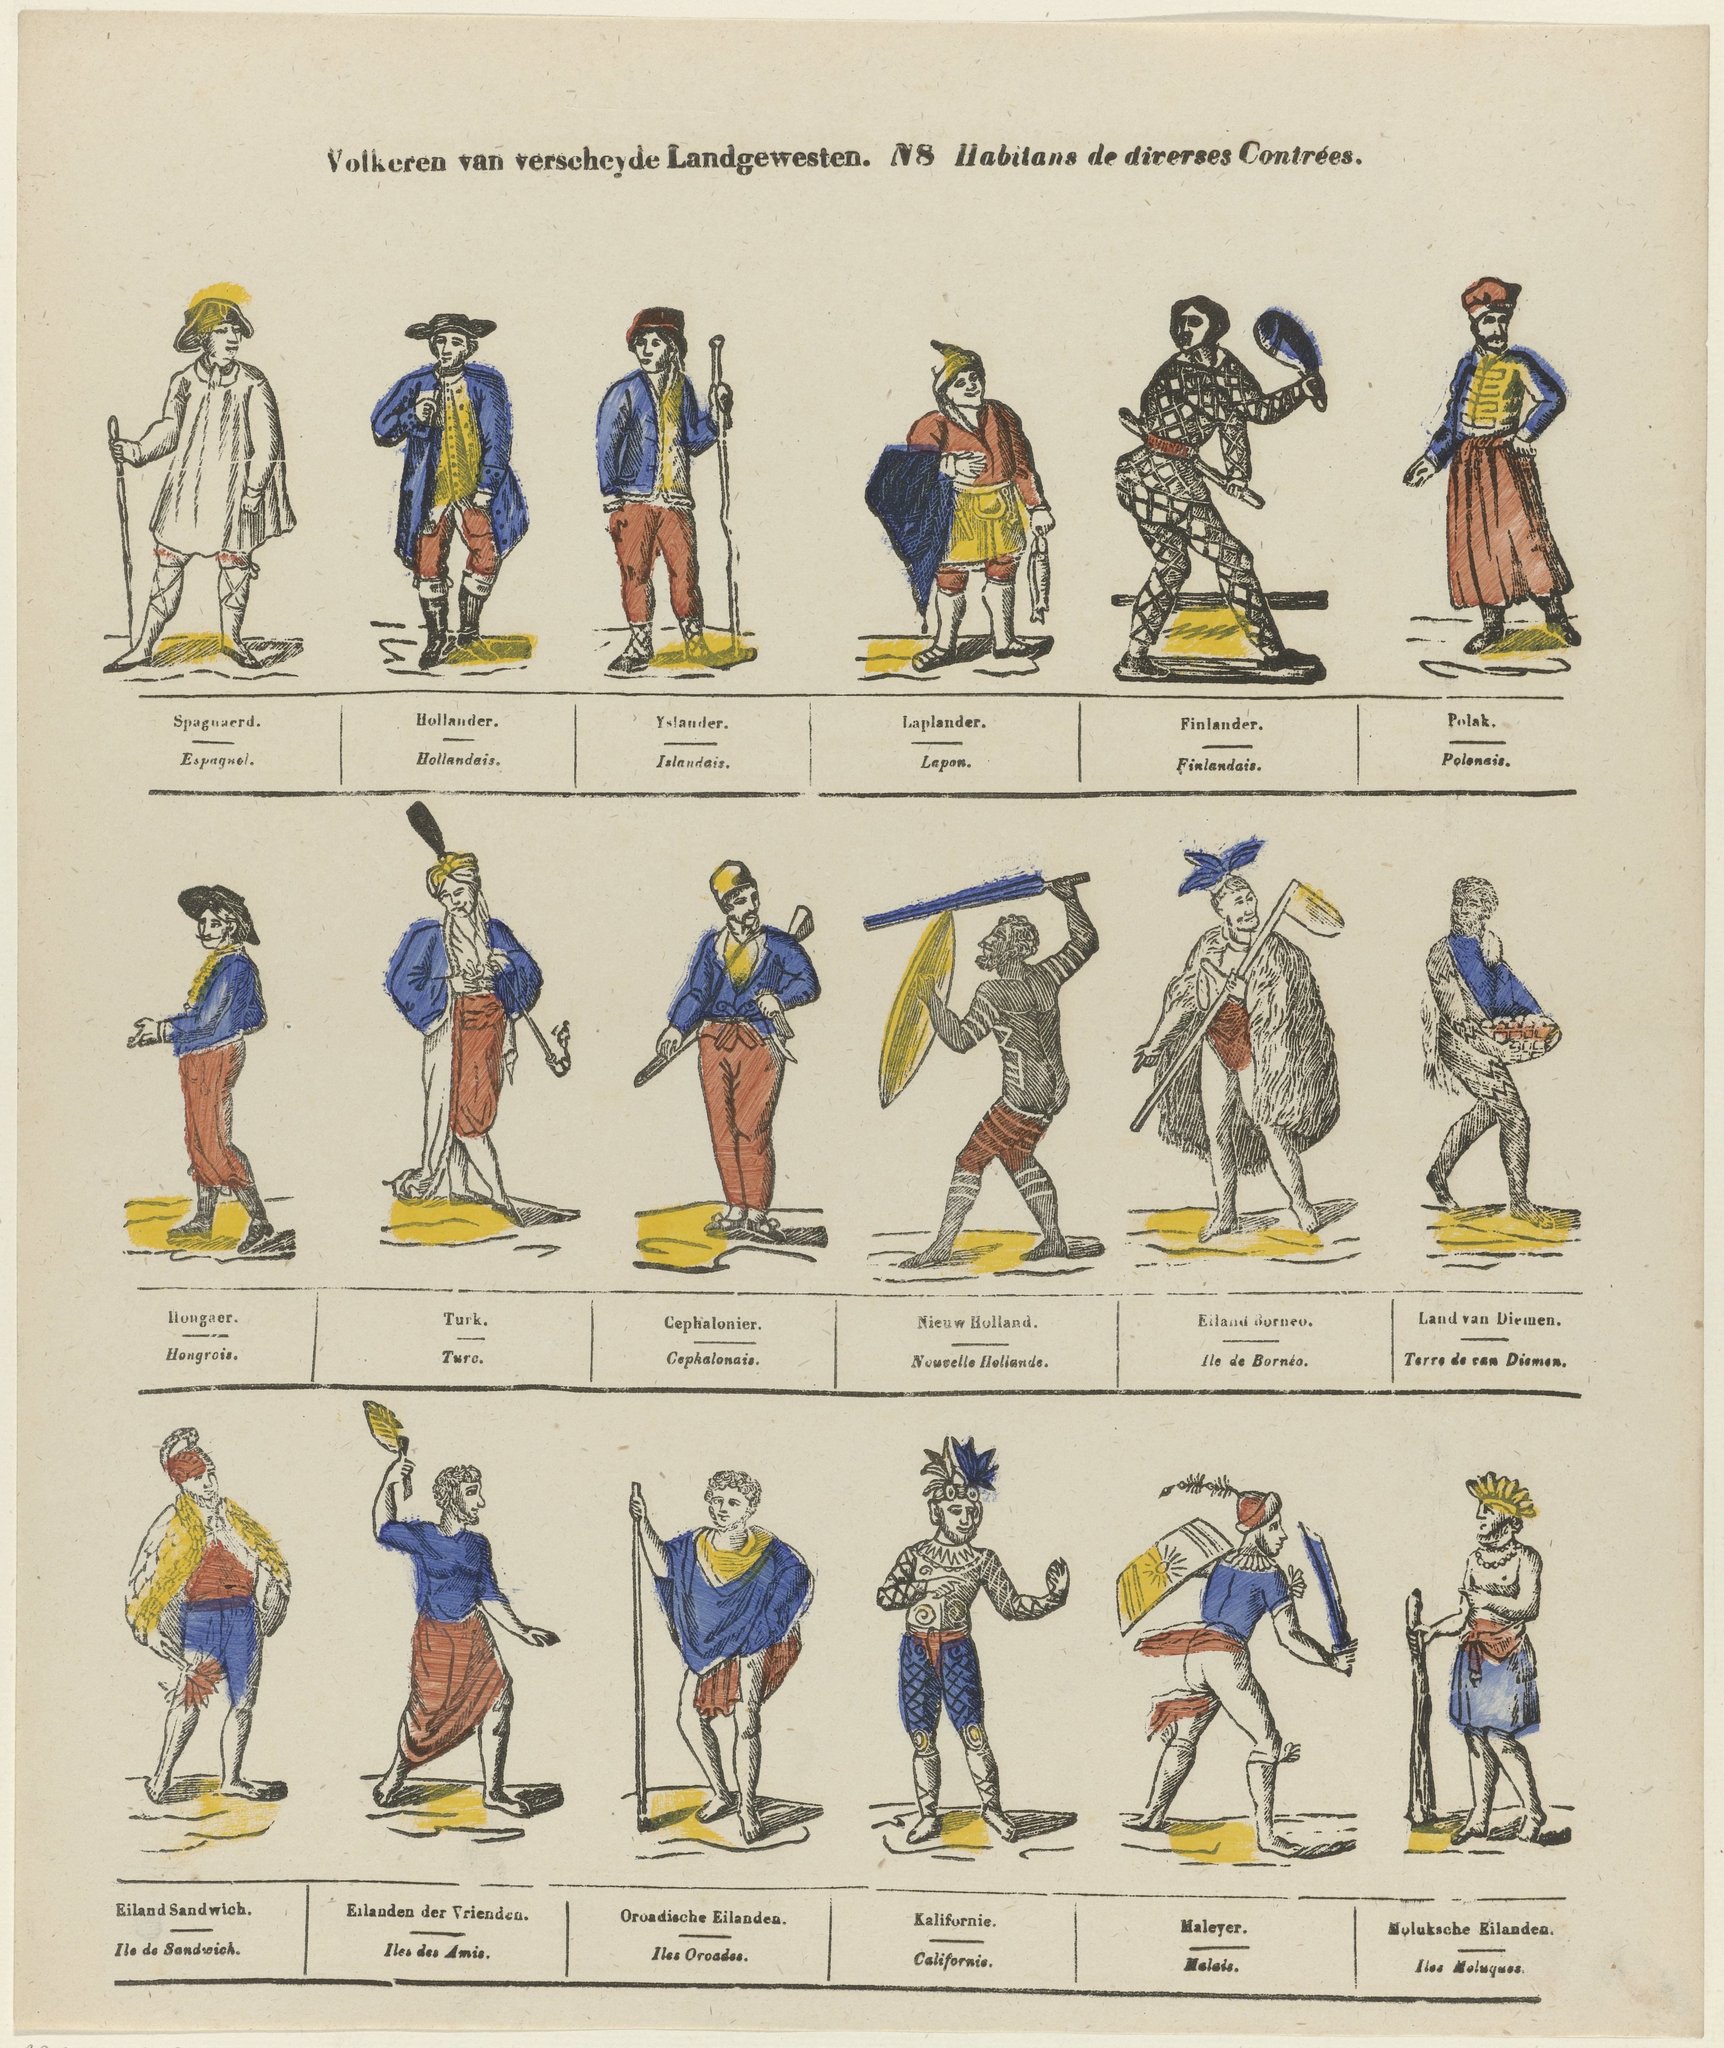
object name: print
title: Volkeren van verscheyde landgewesten / Habitans de diverses Contrées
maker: Anonymous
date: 1833-1856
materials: paper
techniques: colour, letterpress printing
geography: turnhout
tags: human races; peoples; nationalities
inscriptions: collector's mark: Lugt 2760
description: Blad met 3 horizontale rijen met in totaal 18 voorstellingen van mensen uit verschillende landen, zoals een Hollander, een Laplander, een Turk en een Pool. Onder elk figuur een onderschrift in het Nederlands en in het Frans. Genummerd midden boven: N8.